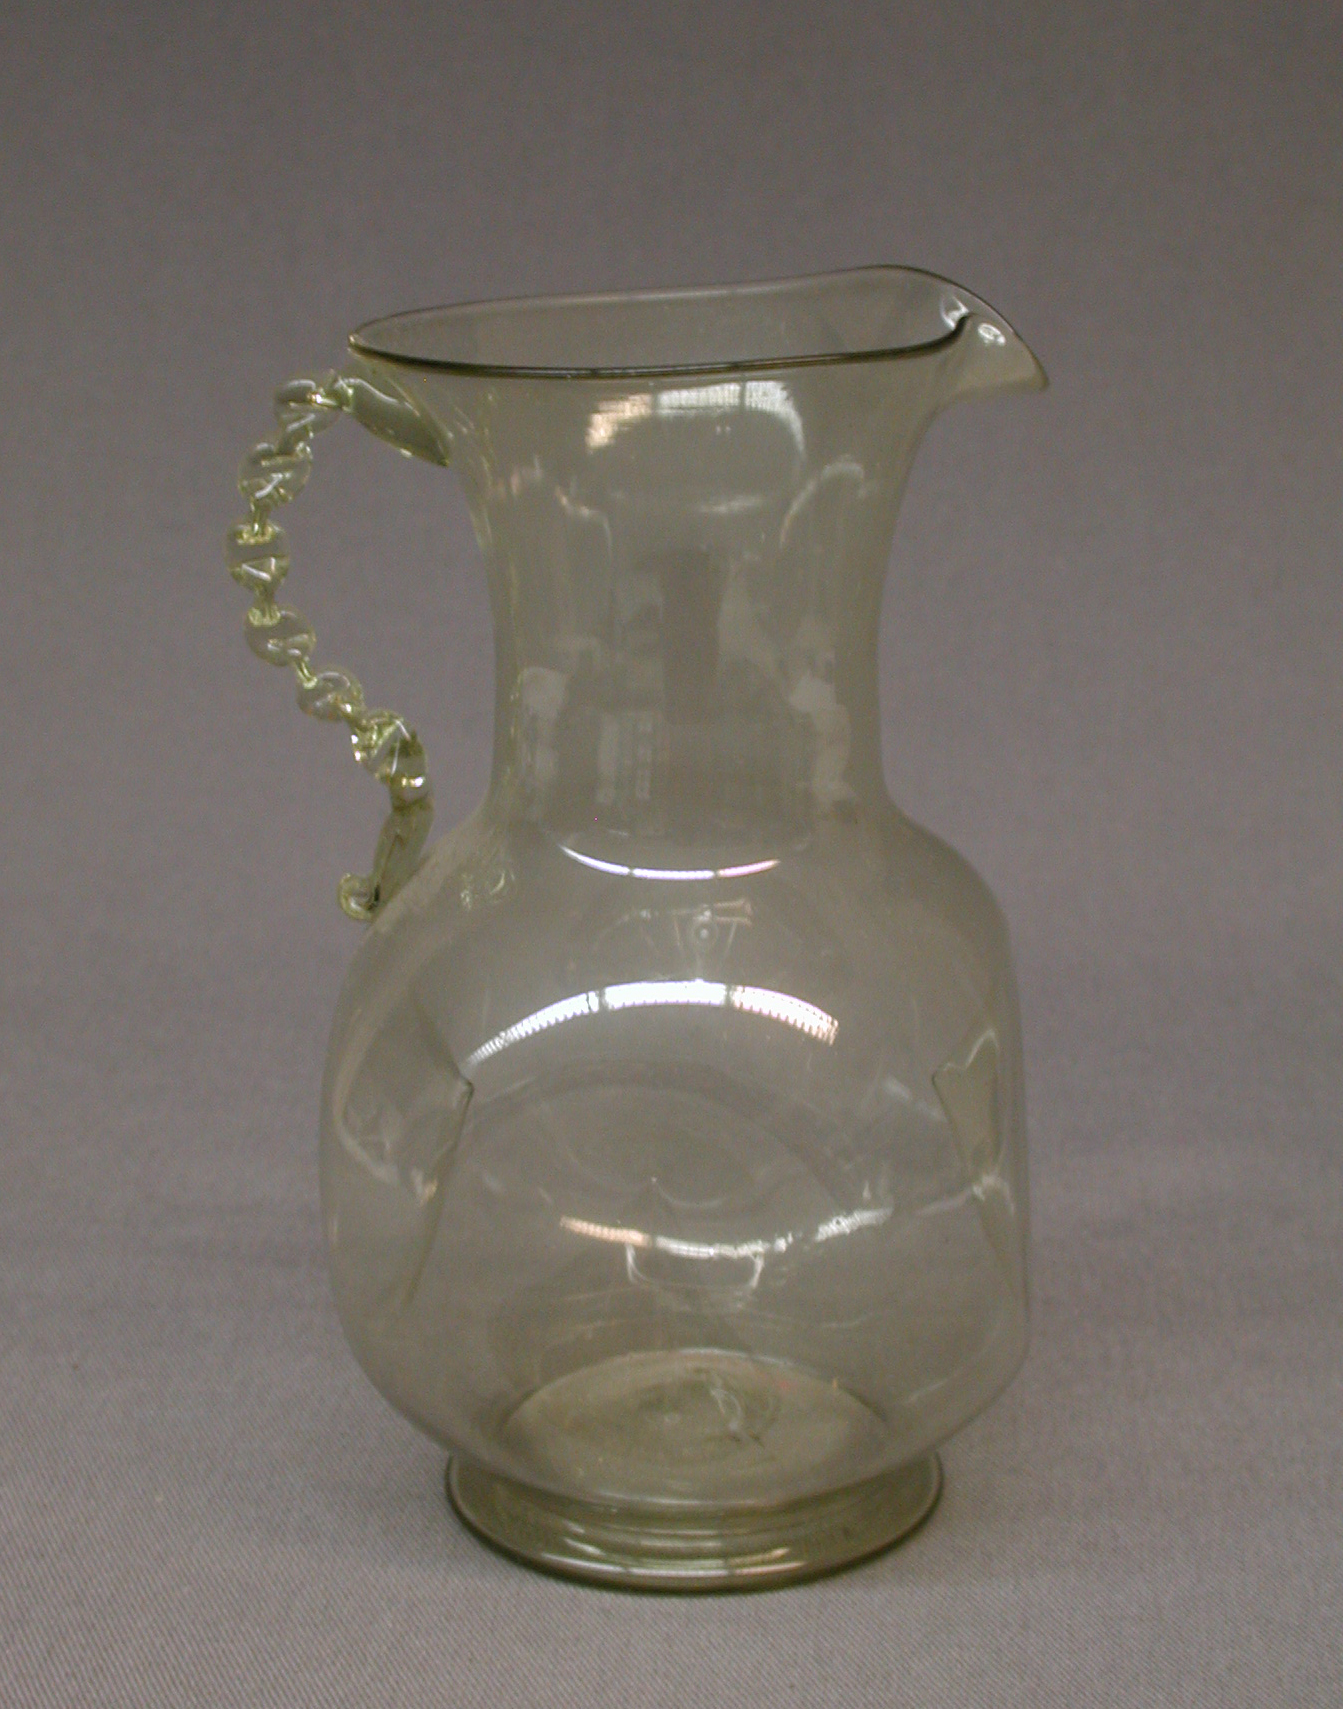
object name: jug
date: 1701-1800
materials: glass